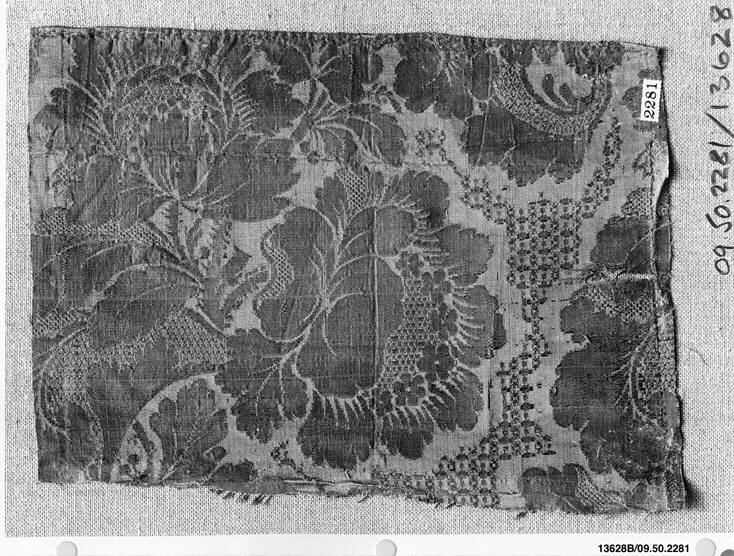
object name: piece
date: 1701-1733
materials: silk